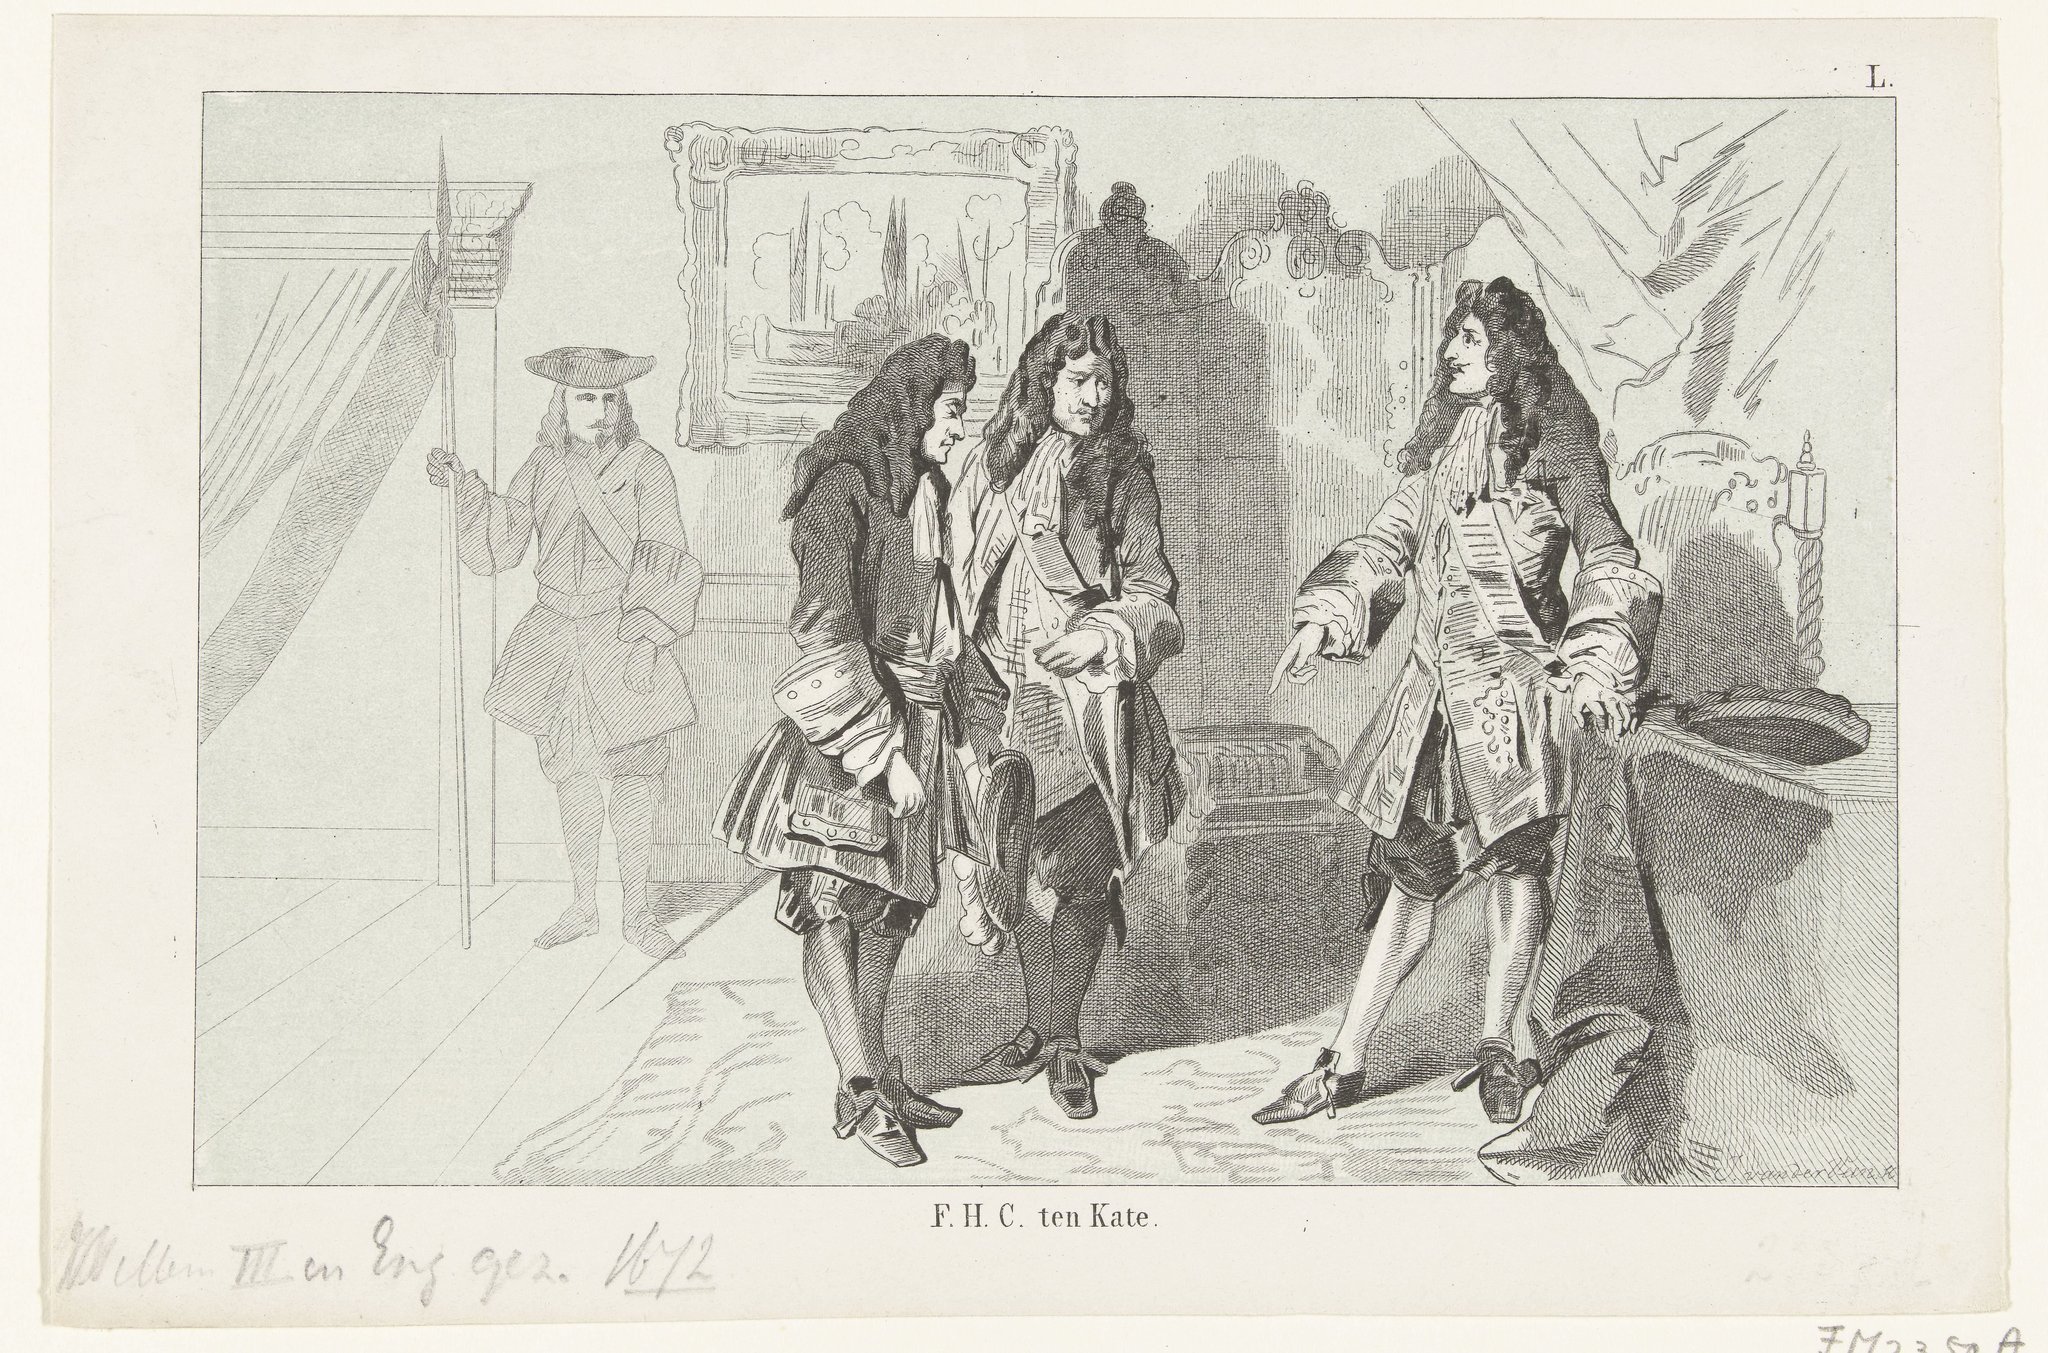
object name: history print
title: Antwoord van Willem III aan de Engelse gezanten, 1672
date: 1853-1861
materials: paper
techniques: tone lithography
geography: netherlands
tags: the hague, william iii (prince of orange and king of england, scotland, and ireland), rampjaar (disaster year)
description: Gebruikt als illustratie in: Jacob van Lennep, De geschiedenis des vaderlands in schetsen en afbeeldingen, Binger, Amsterdam 1855-1861, 8 delen, pl. L. Dit nummer is een door het RPK toegevoegd nummer en staat niet in Frederik Muller, het werk waar de prent voor is gemaakt of uit afkomstig is, staat wel vermeld in Frederik Muller.